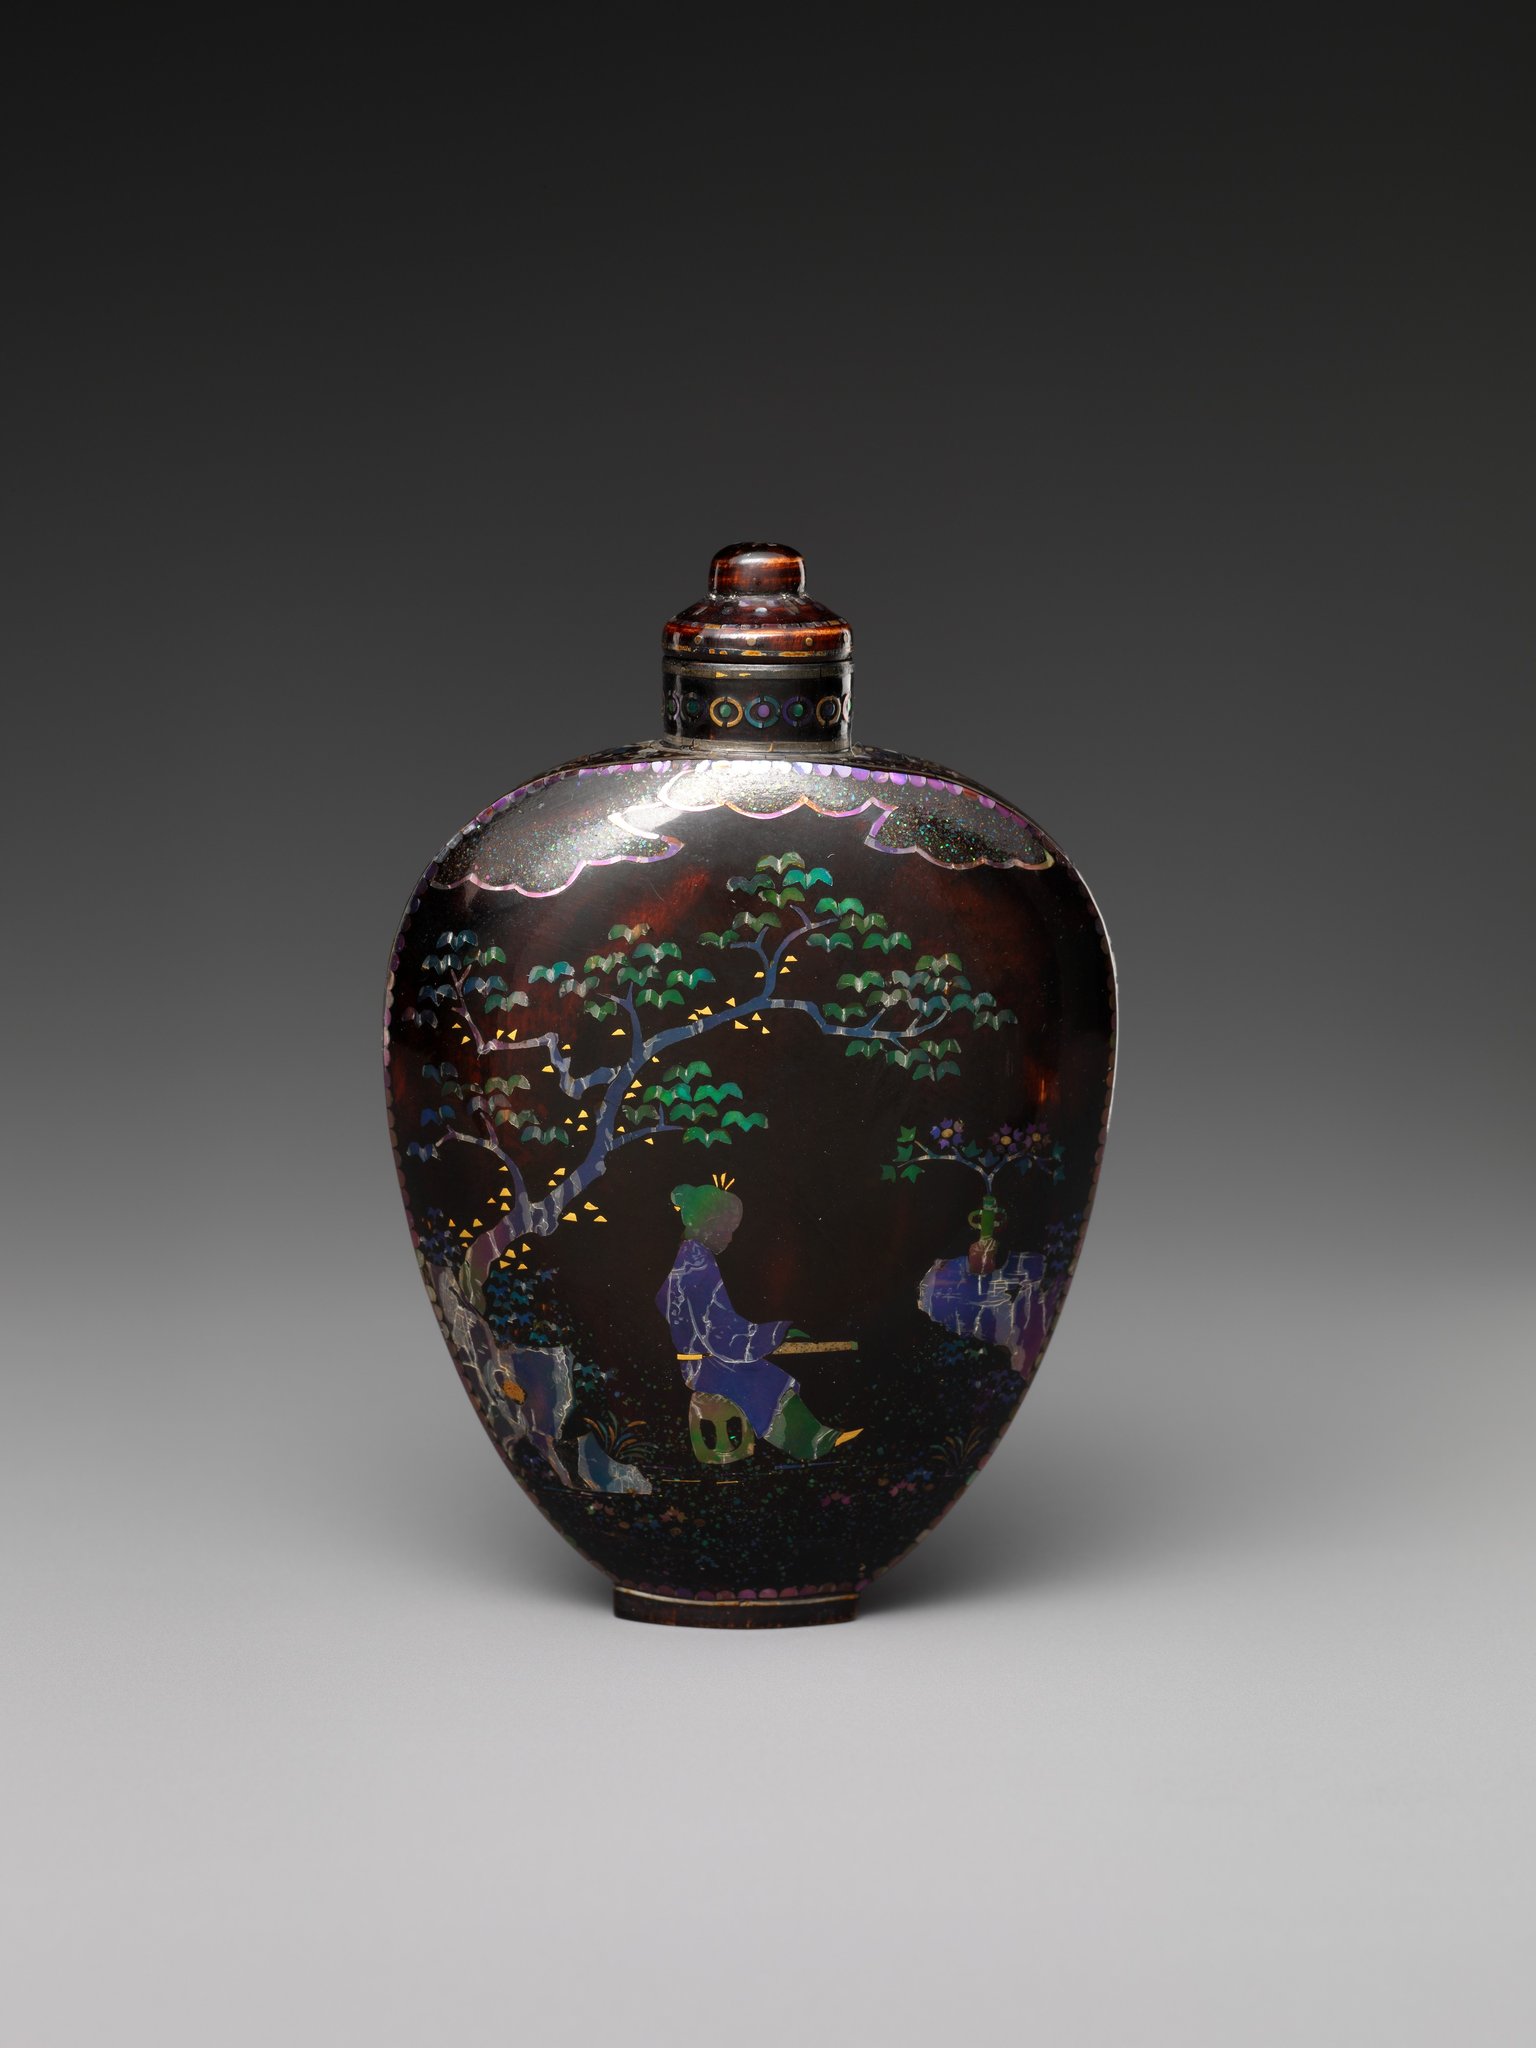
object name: snuff bottle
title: Snuff bottle with woman in a garden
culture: chinese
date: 1701-1800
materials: lacquer, mother of pearl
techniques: inlay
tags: women,trees